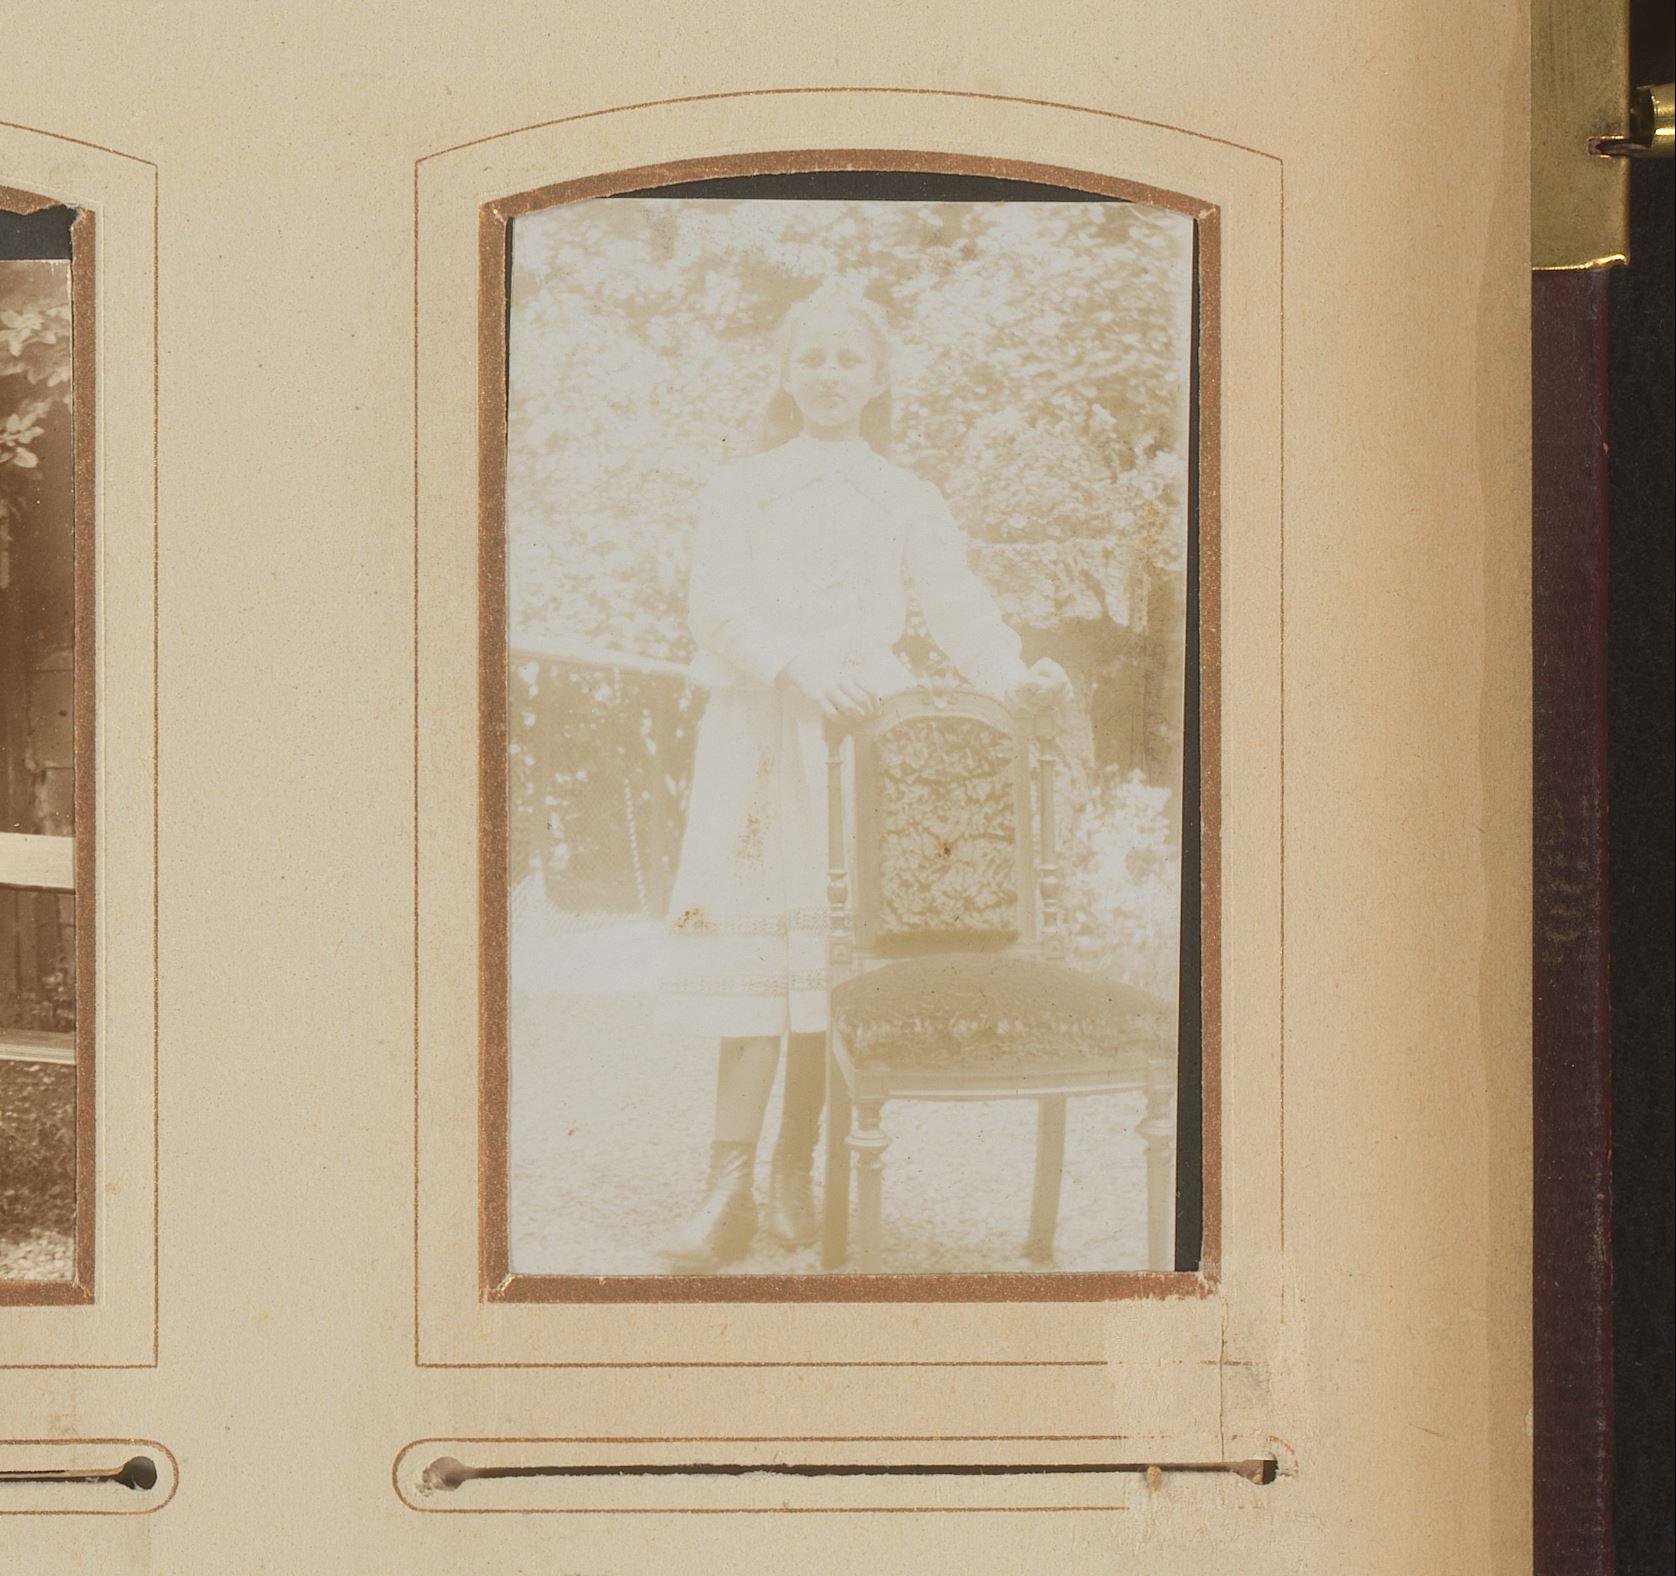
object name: carte de visite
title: Portret van een meisje, staand bij een stoel in een tuin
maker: Anonymous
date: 1880-1920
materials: cardboard, photographic support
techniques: collodion silver print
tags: historical persons - bb - woman, garden, girl (child between toddler and youth), chair